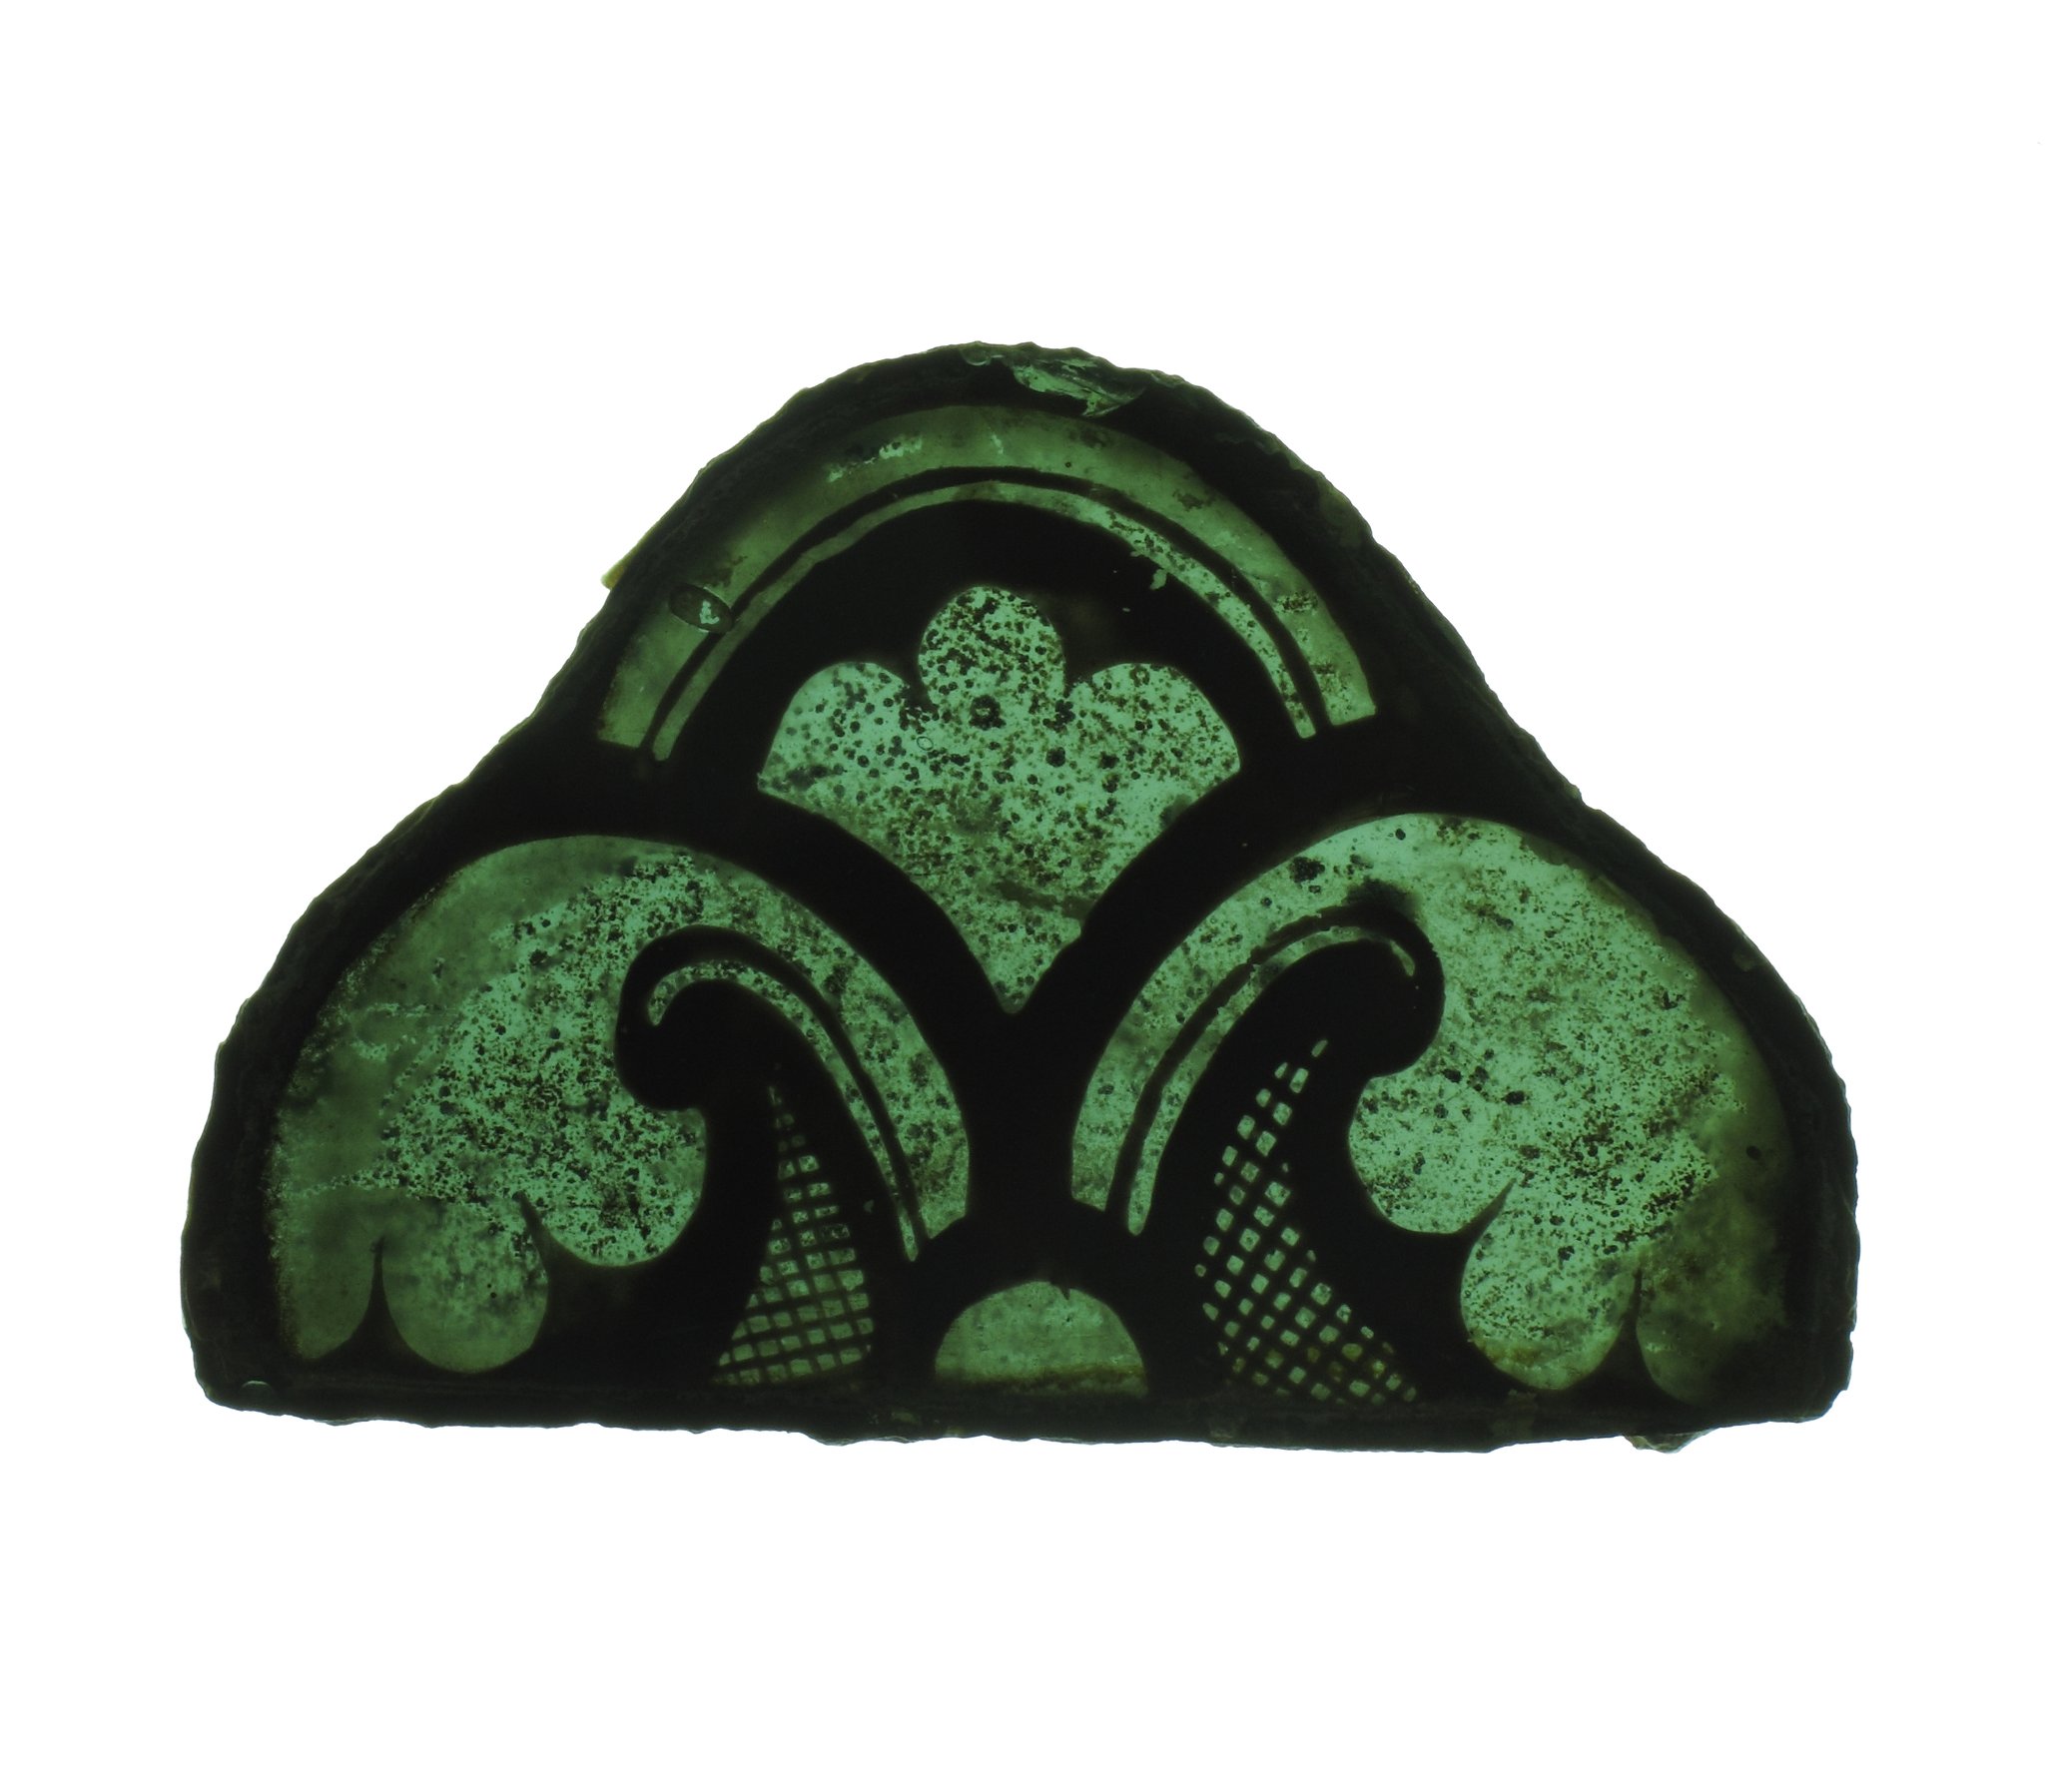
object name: fragment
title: Glass Fragment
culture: french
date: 1101-1400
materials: glass, metal, paint